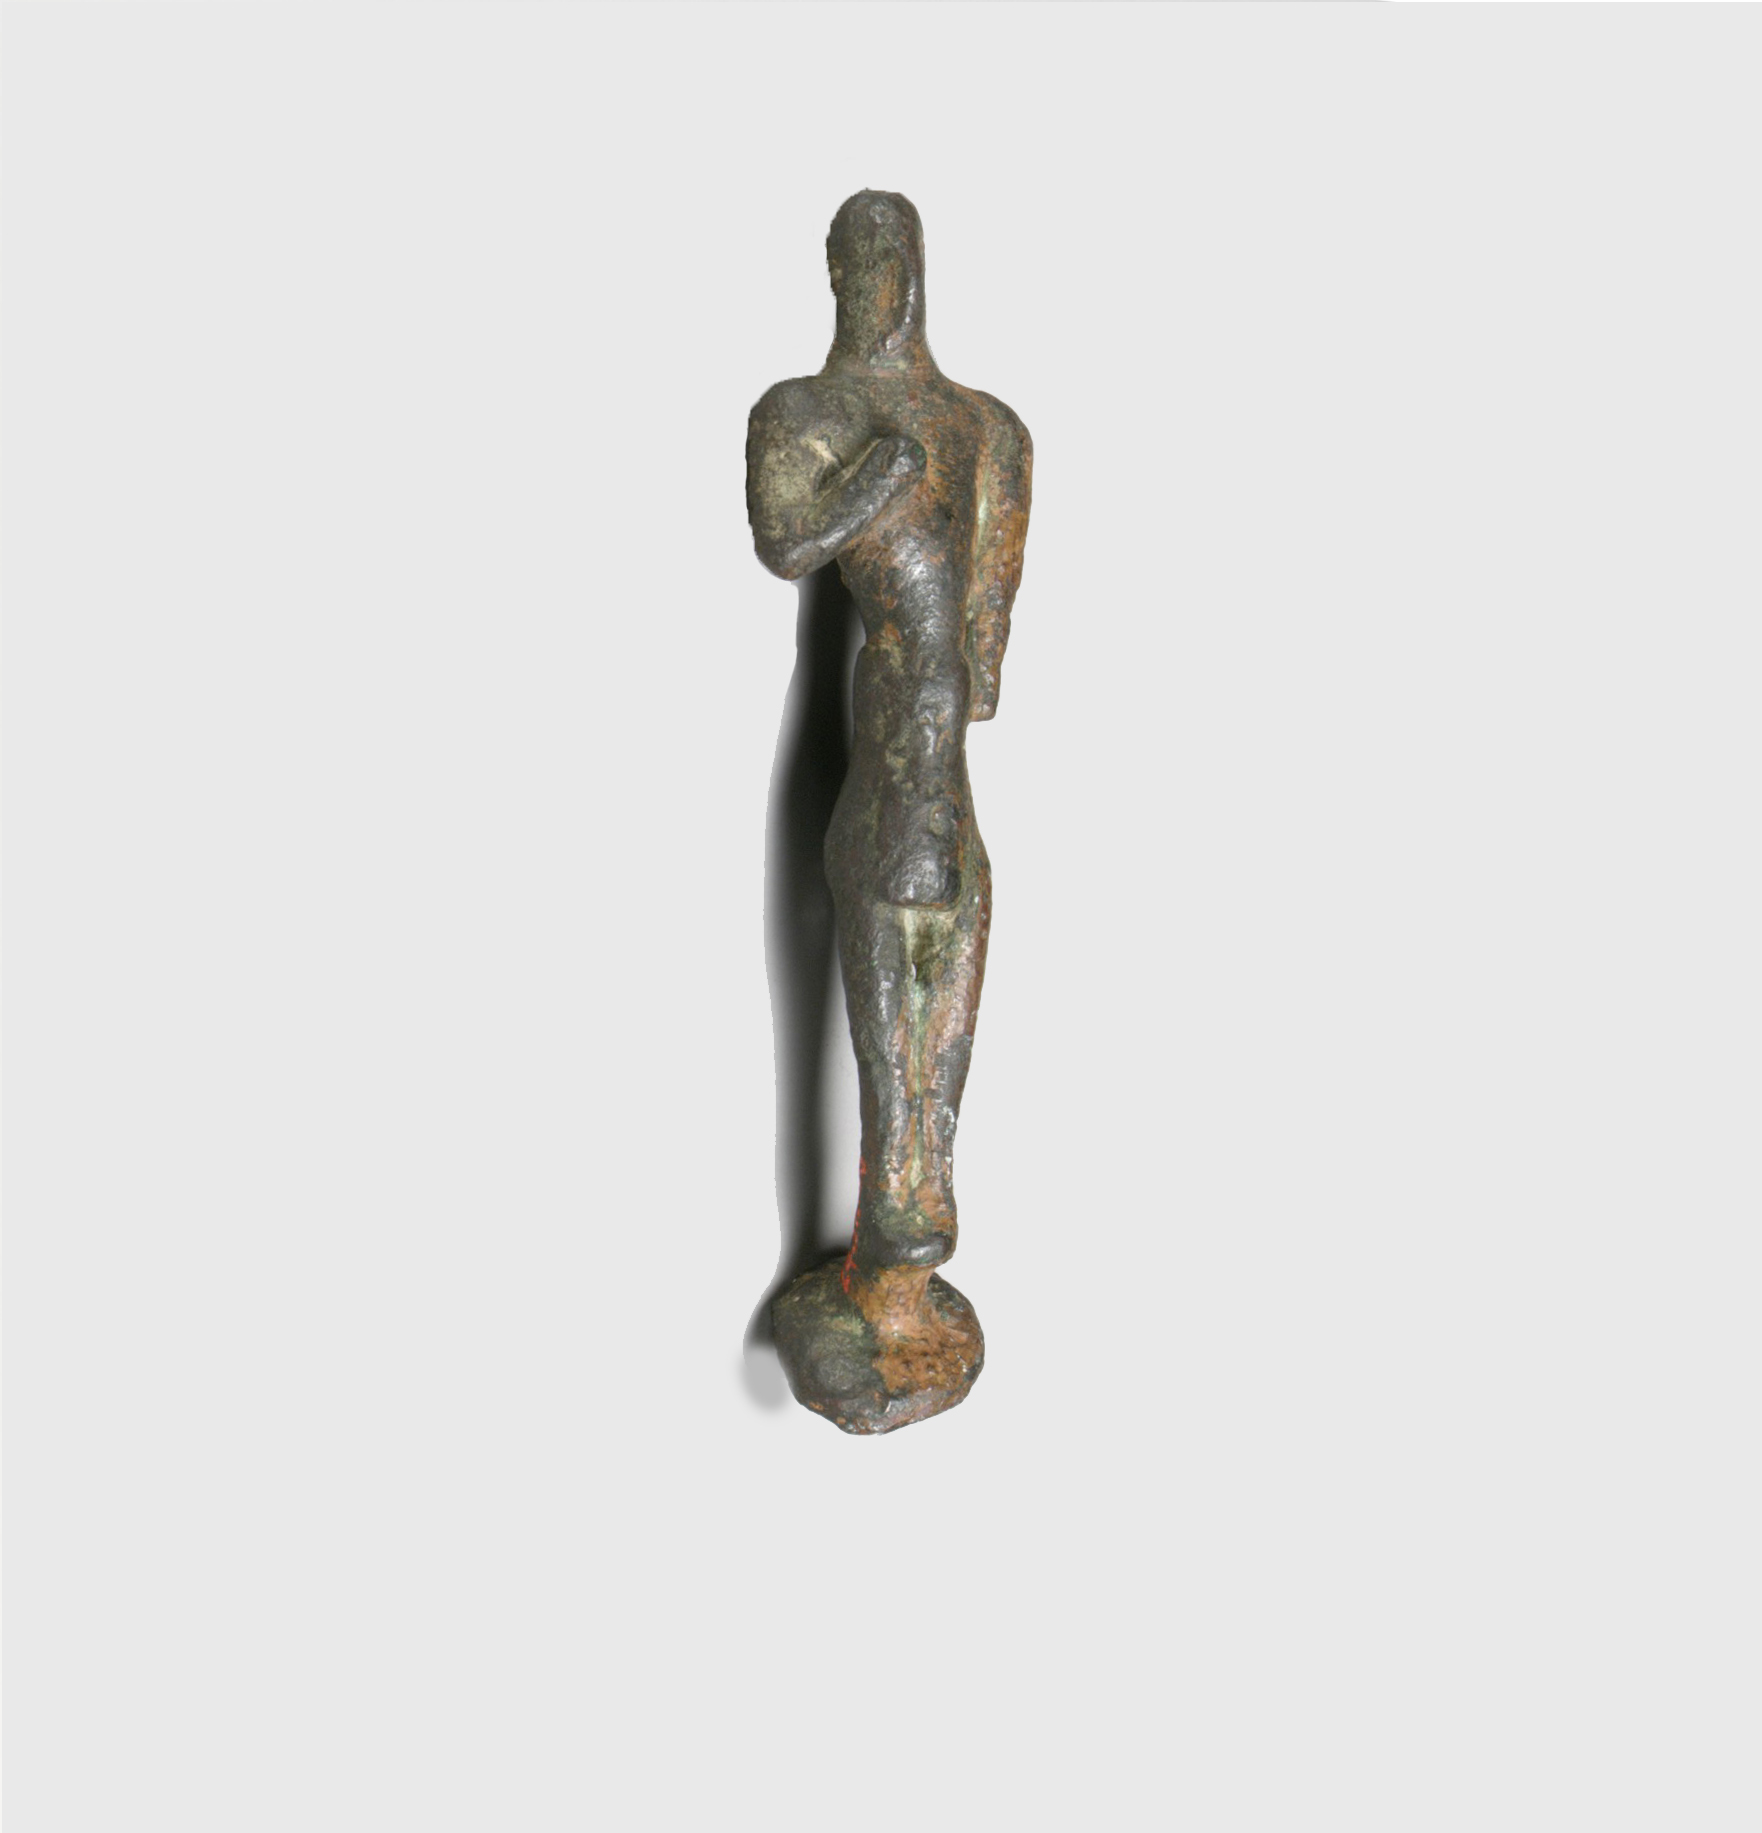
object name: statuette of a man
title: Bronze statuette of a male votary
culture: minoan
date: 1400-1300 BCE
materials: bronze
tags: men